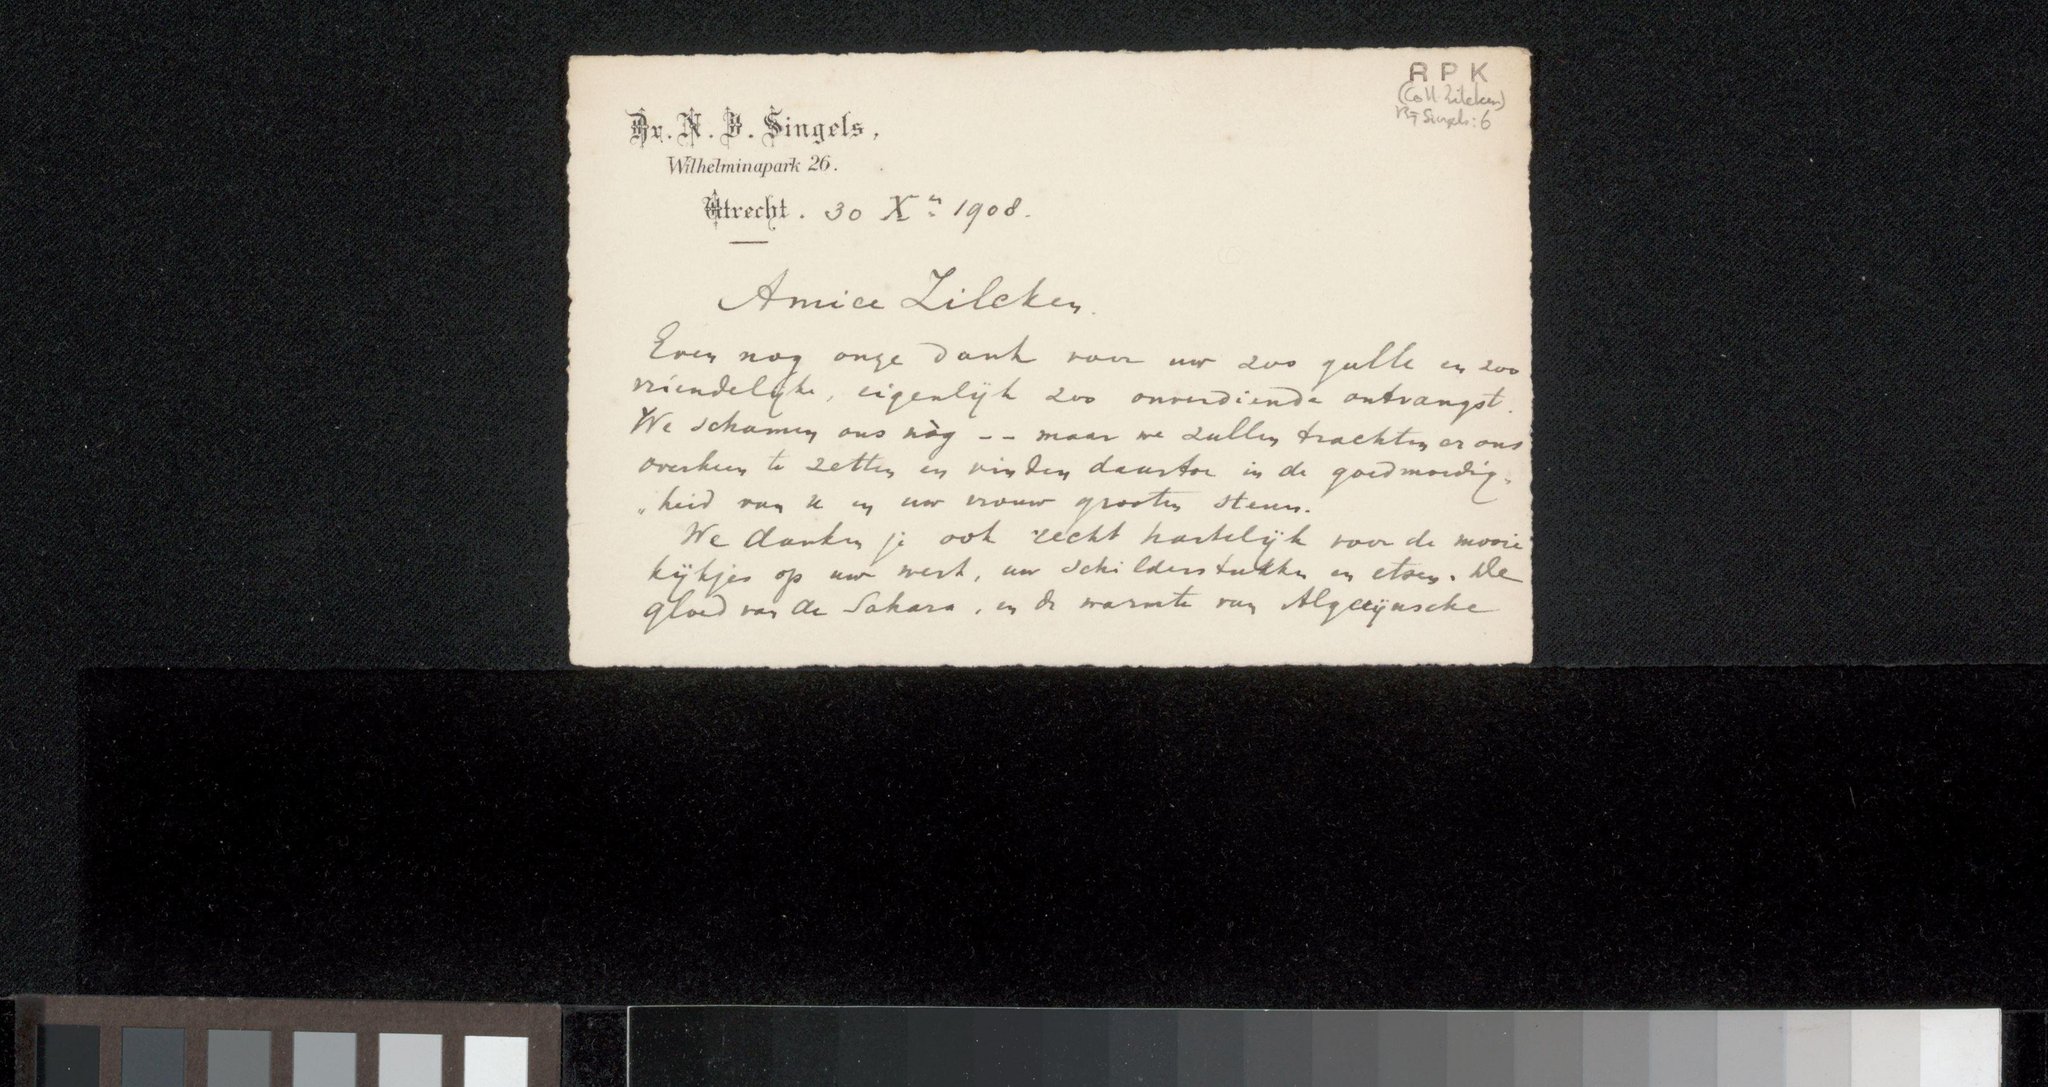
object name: letter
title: Brief aan Philip Zilcken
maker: n.j. singels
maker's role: leraar, schrijver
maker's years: 1857-1931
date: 1908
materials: cardboard, ink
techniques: pen, printing, writing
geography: utrecht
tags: the hague, painter, philip zilcken, the graphic arts, painting (including book-illumination, miniature-painting), utrecht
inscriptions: collector's mark: ‘RPK’